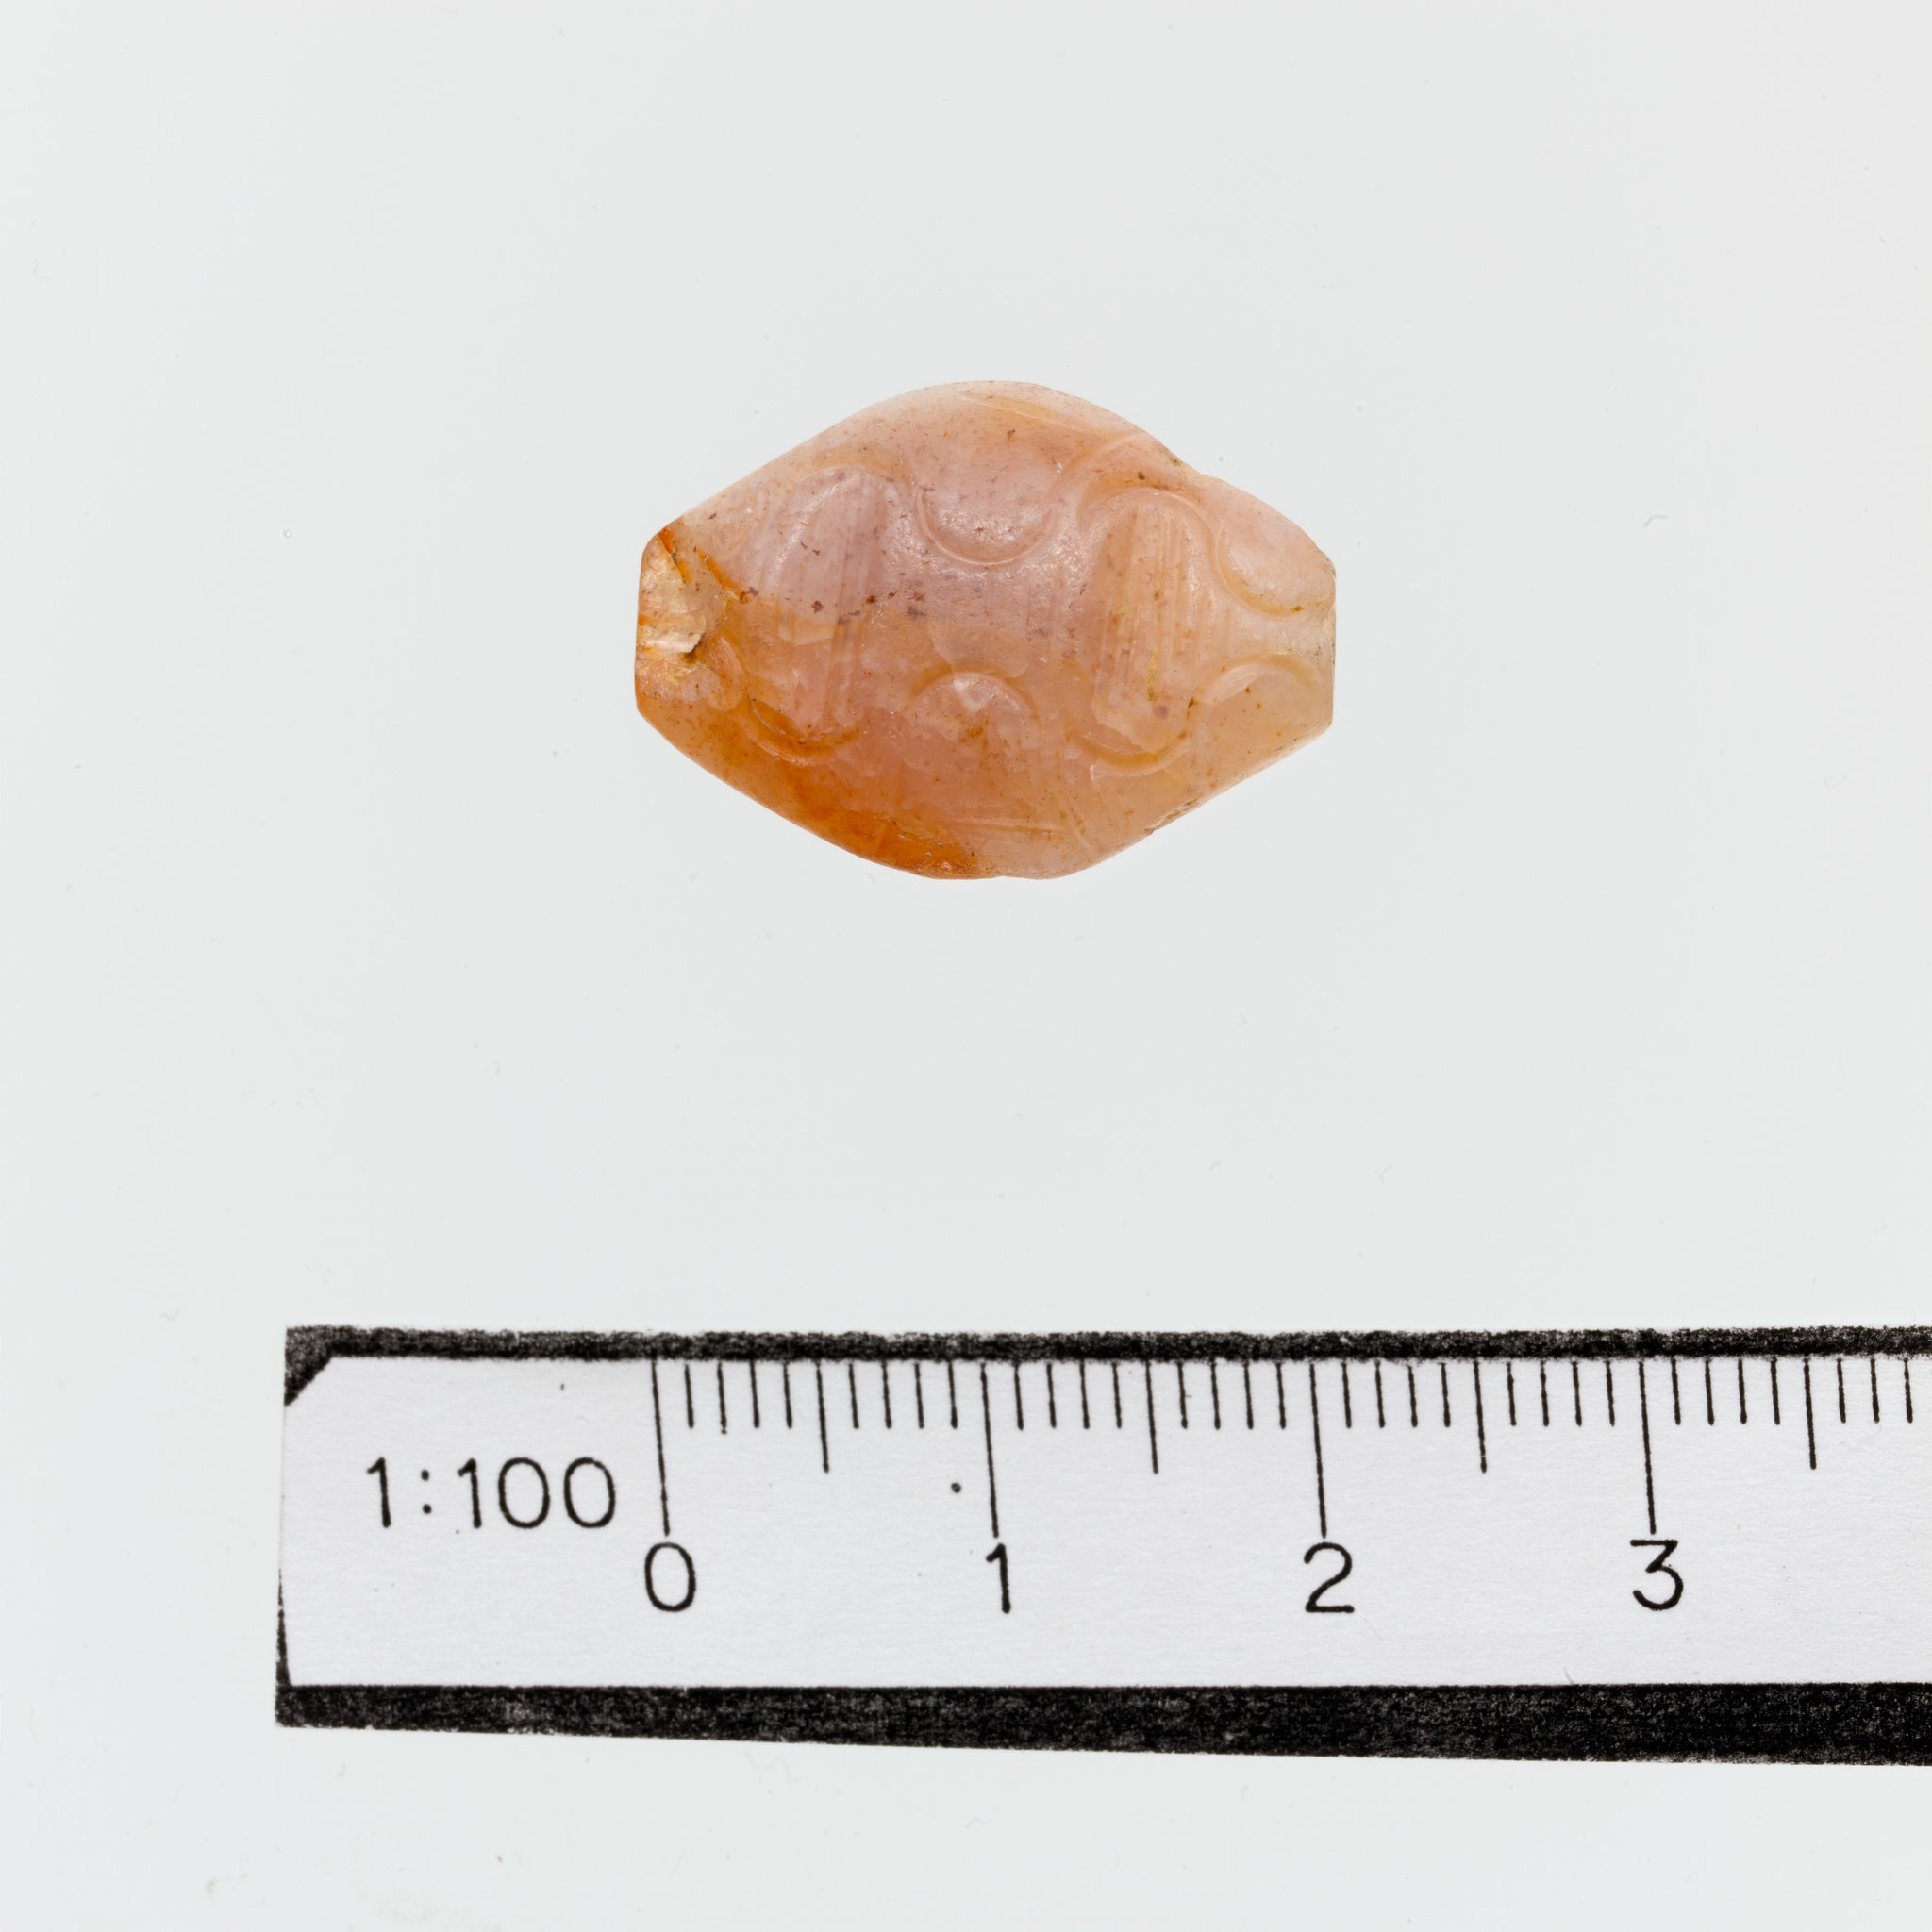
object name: seal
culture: minoan, crete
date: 2000-1450 BCE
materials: stone